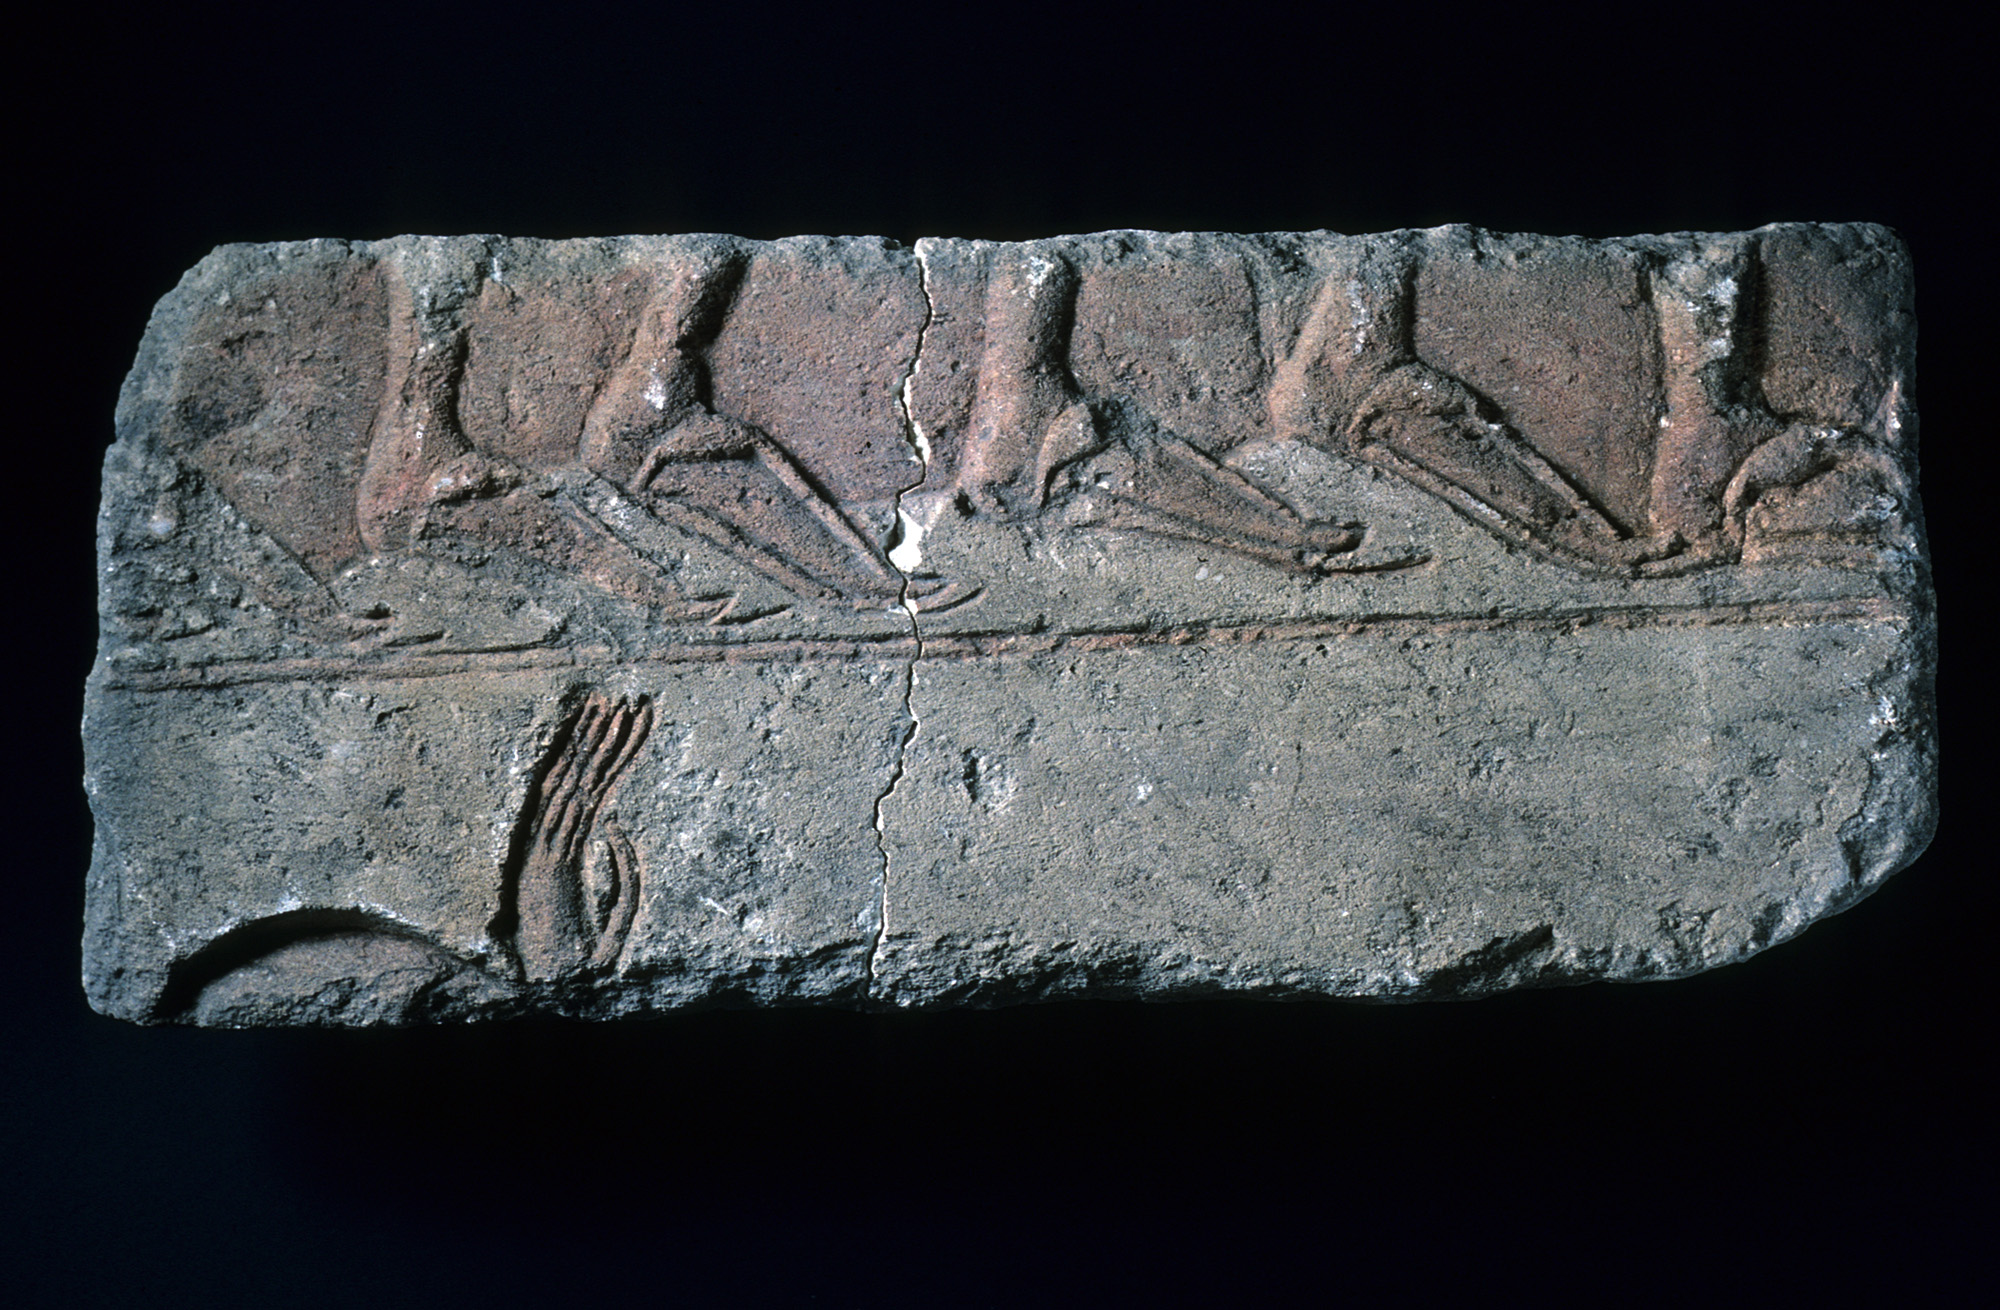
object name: talatat, sandalled foot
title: Relief fragment with sandalled feet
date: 1353-1336 BCE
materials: limestone, paint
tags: feet